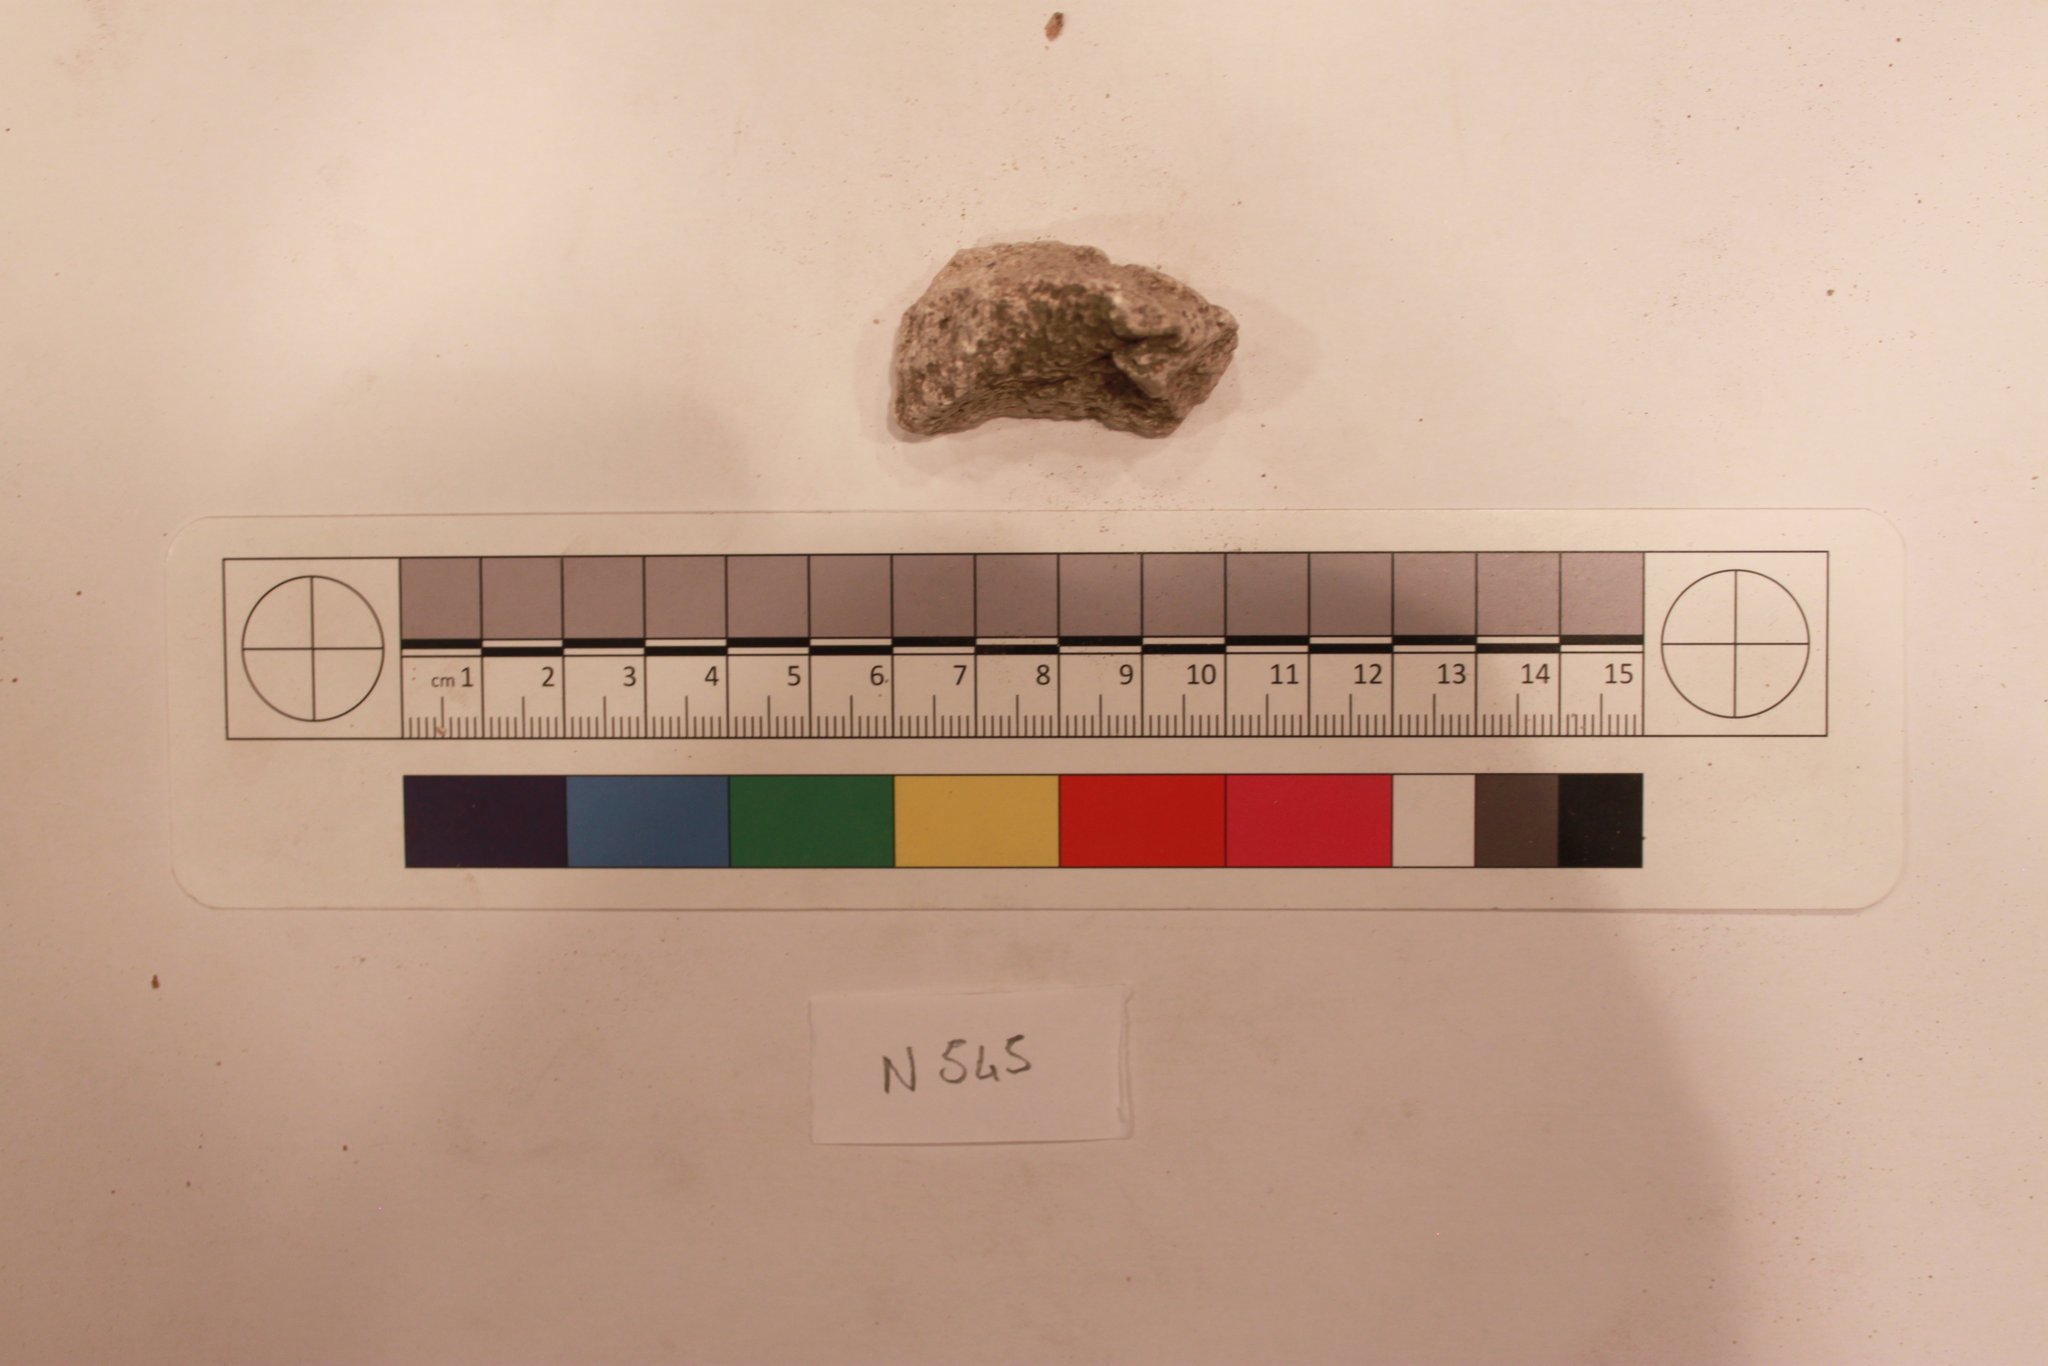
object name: fragment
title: Stucco Fragment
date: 701-1200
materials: plaster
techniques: carving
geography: iran